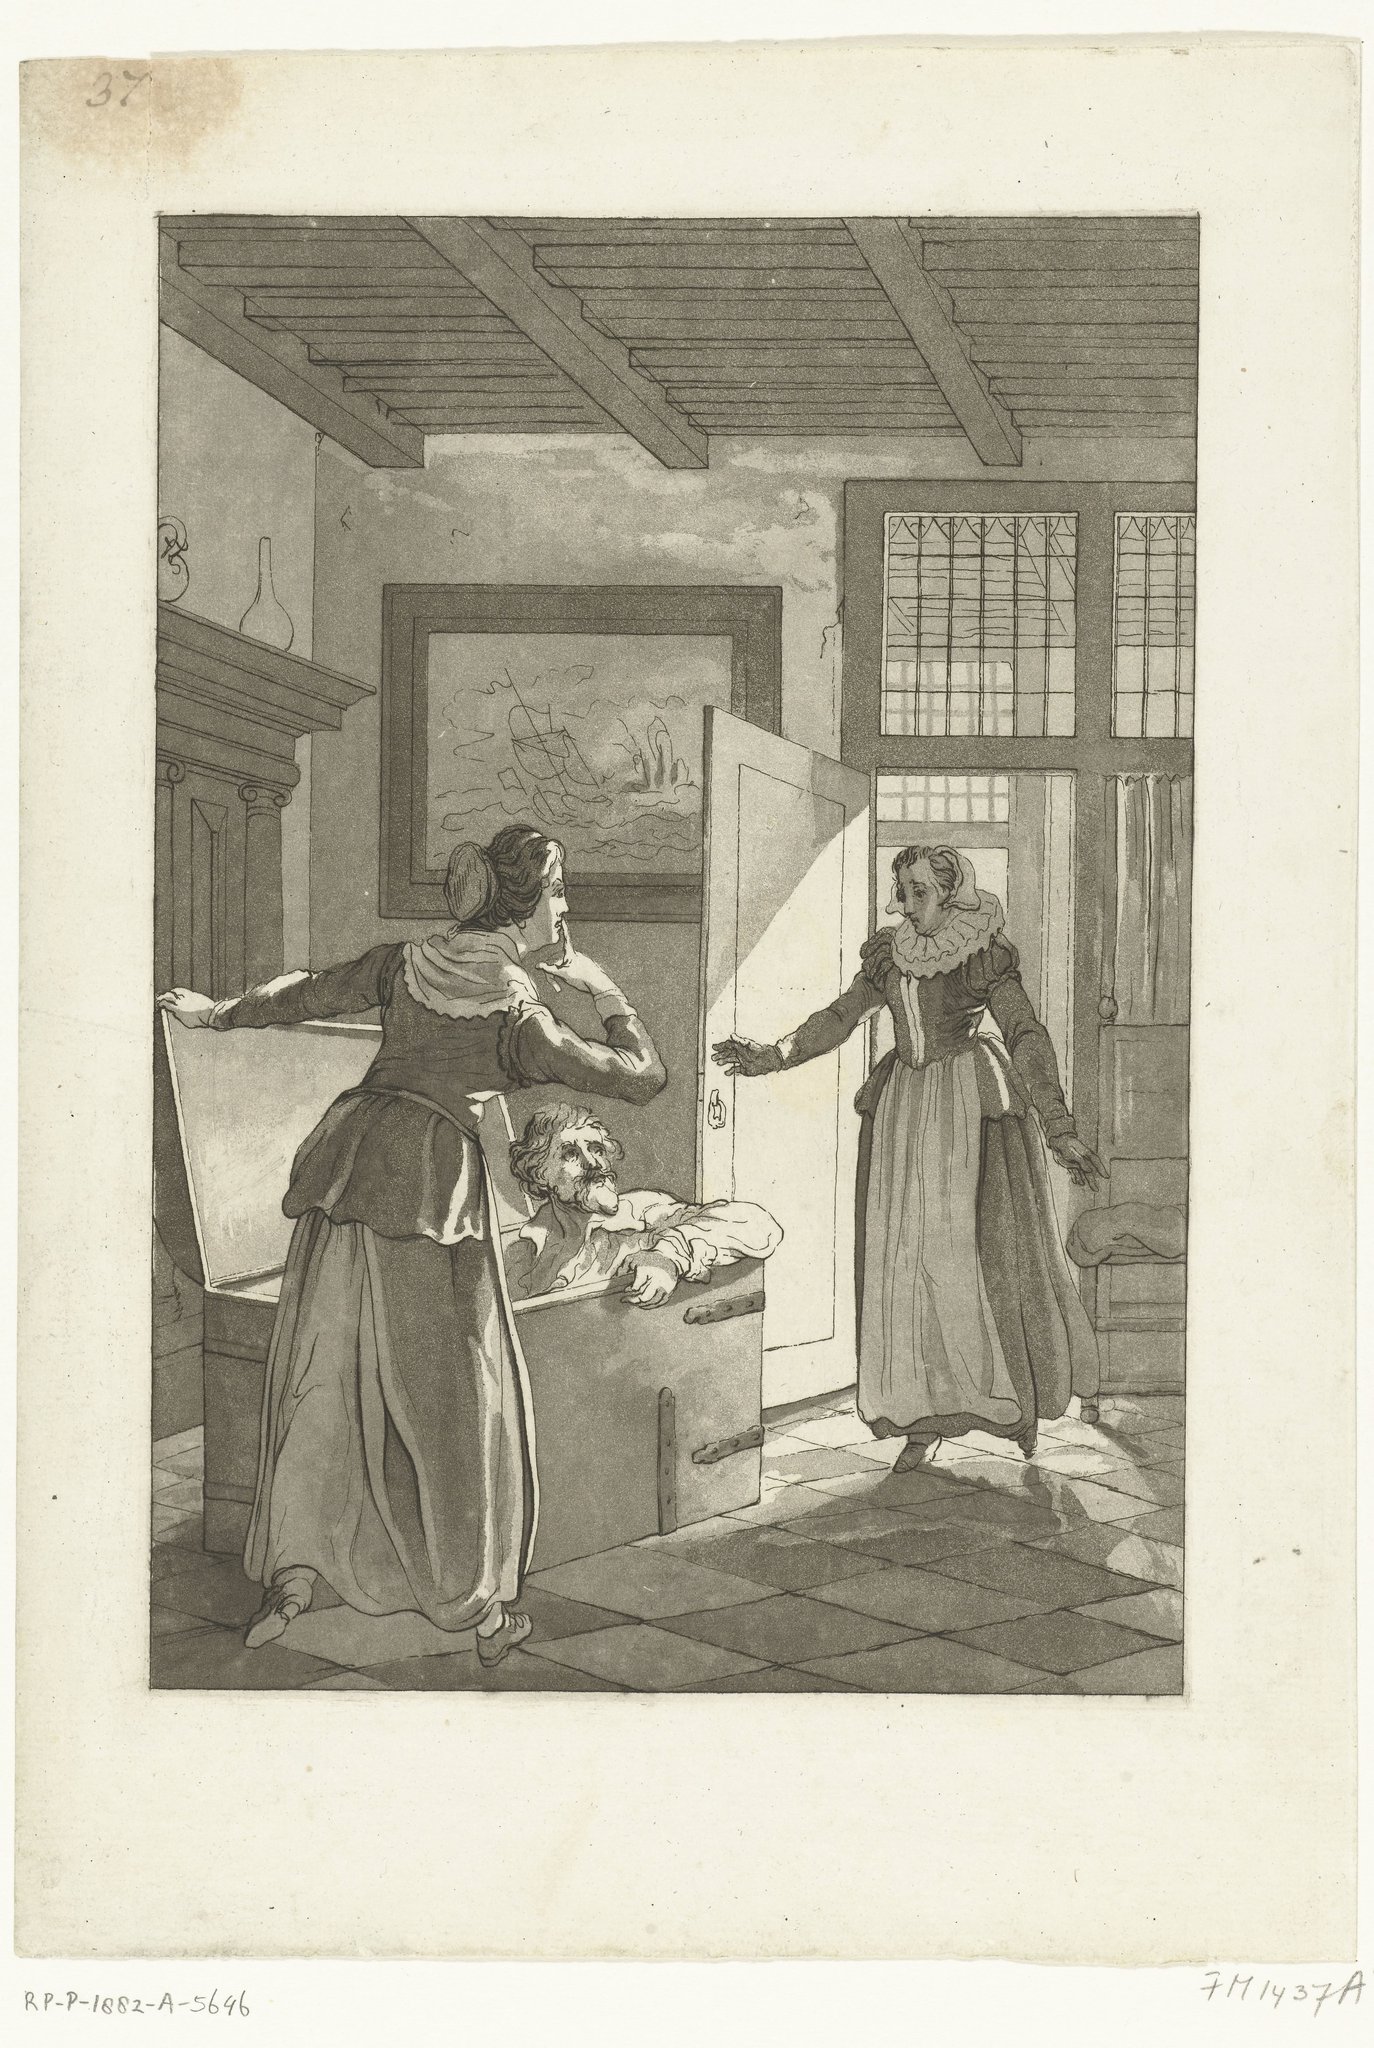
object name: print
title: Elsje van Houweningen betrapt Hugo de Groot in de boekenkist, 1621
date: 1800-1824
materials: paper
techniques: aquatint, etching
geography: netherlands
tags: delft, hugo de groot, the hague, law and jurisprudence (+ escape from prison), loevestein castle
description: Dienstmeid Elsje van Houweningen betrapt Hugo de Groot die, geholpen door zijn vrouw Maria van Reigersberch, de boekenkist uitprobeert, maart 1621. Van Reigersberch had het plan voor de ontsnapping met de boekenkist bedacht en Van Houweningen zou een grote rol spelen in de uiteindelijke uitvoering ervan.